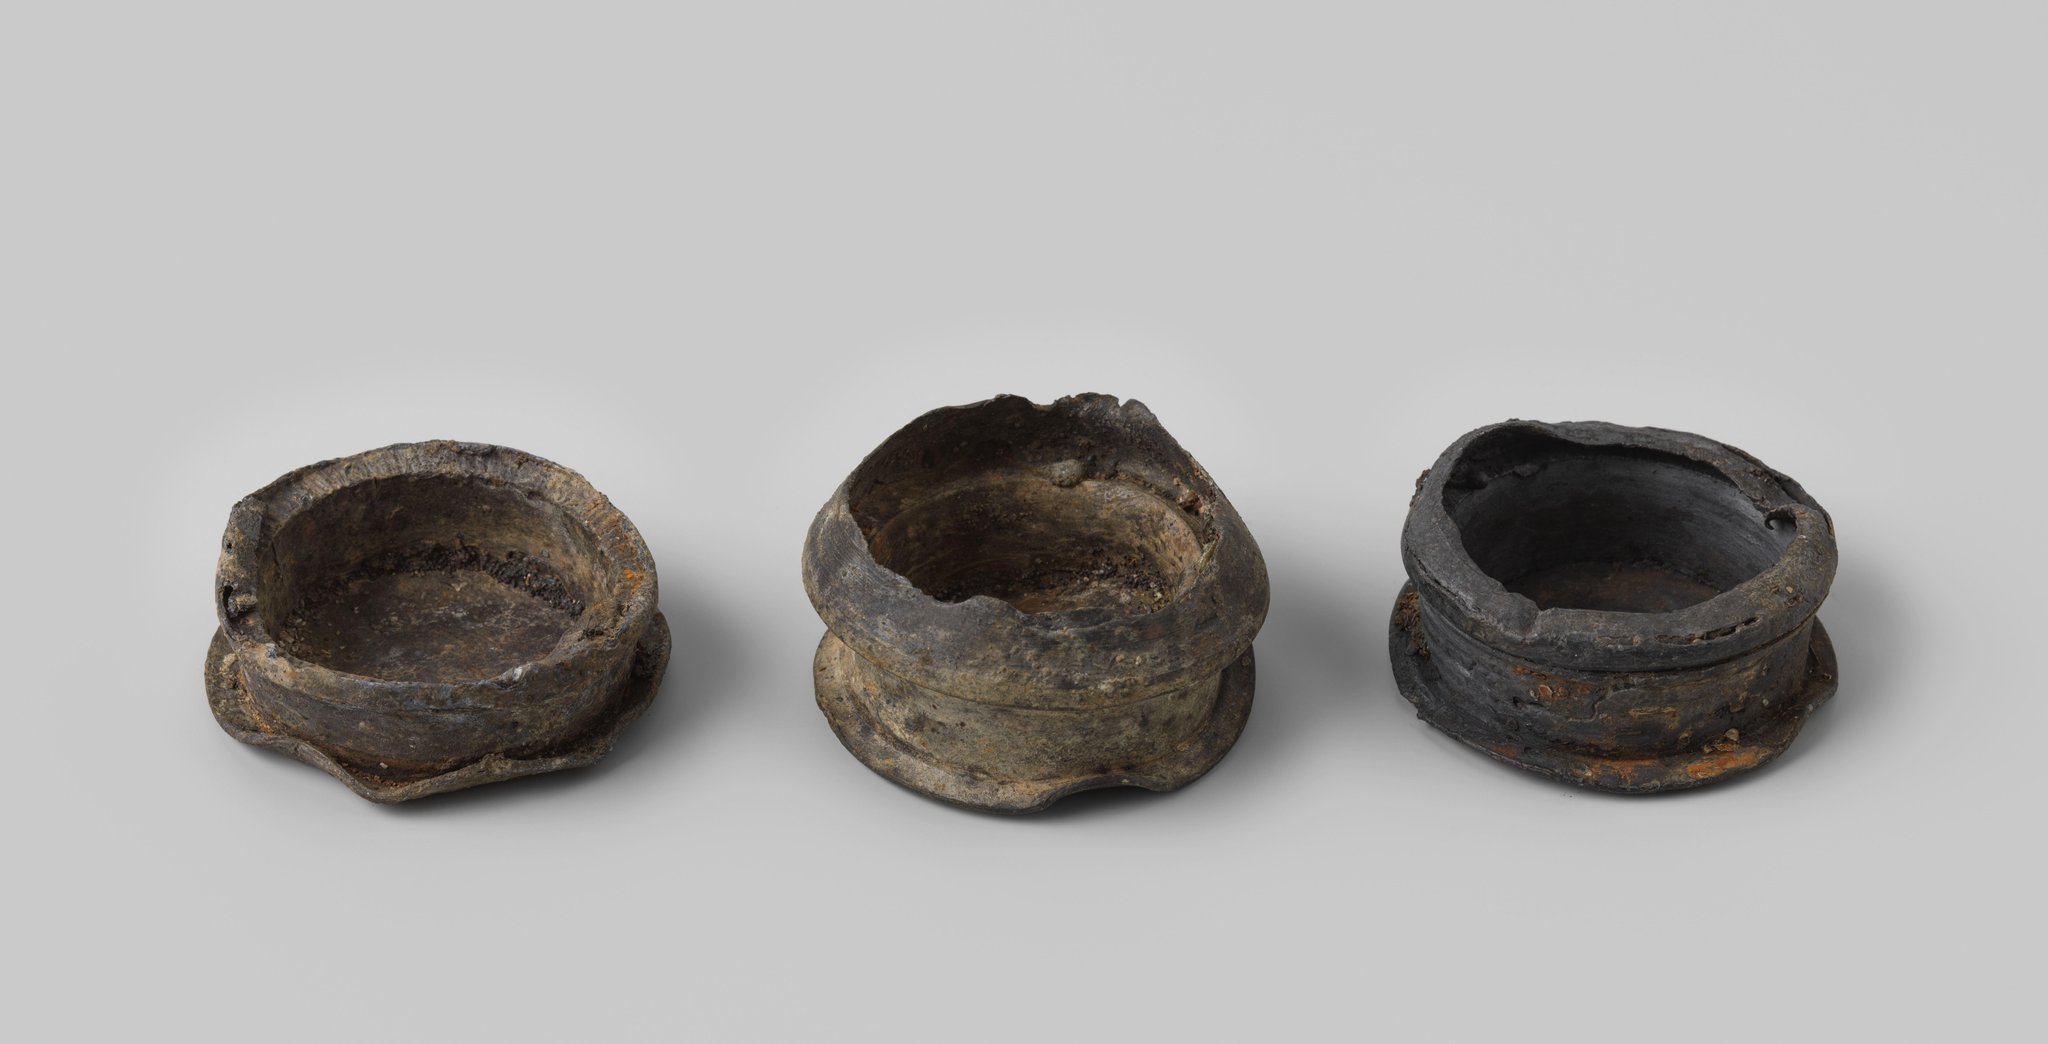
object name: screwcap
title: Schroefdoppen uit het wrak van de Oost-Indiëvaarder Princesse Maria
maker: Anonymous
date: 1670-1686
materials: tin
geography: netherlands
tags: princesse maria (schip), verenigde oostindische compagnie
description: Ronde tinnen schroefdoppen voor een kelderfles, zwart gecorrodeerd. Screw cap.